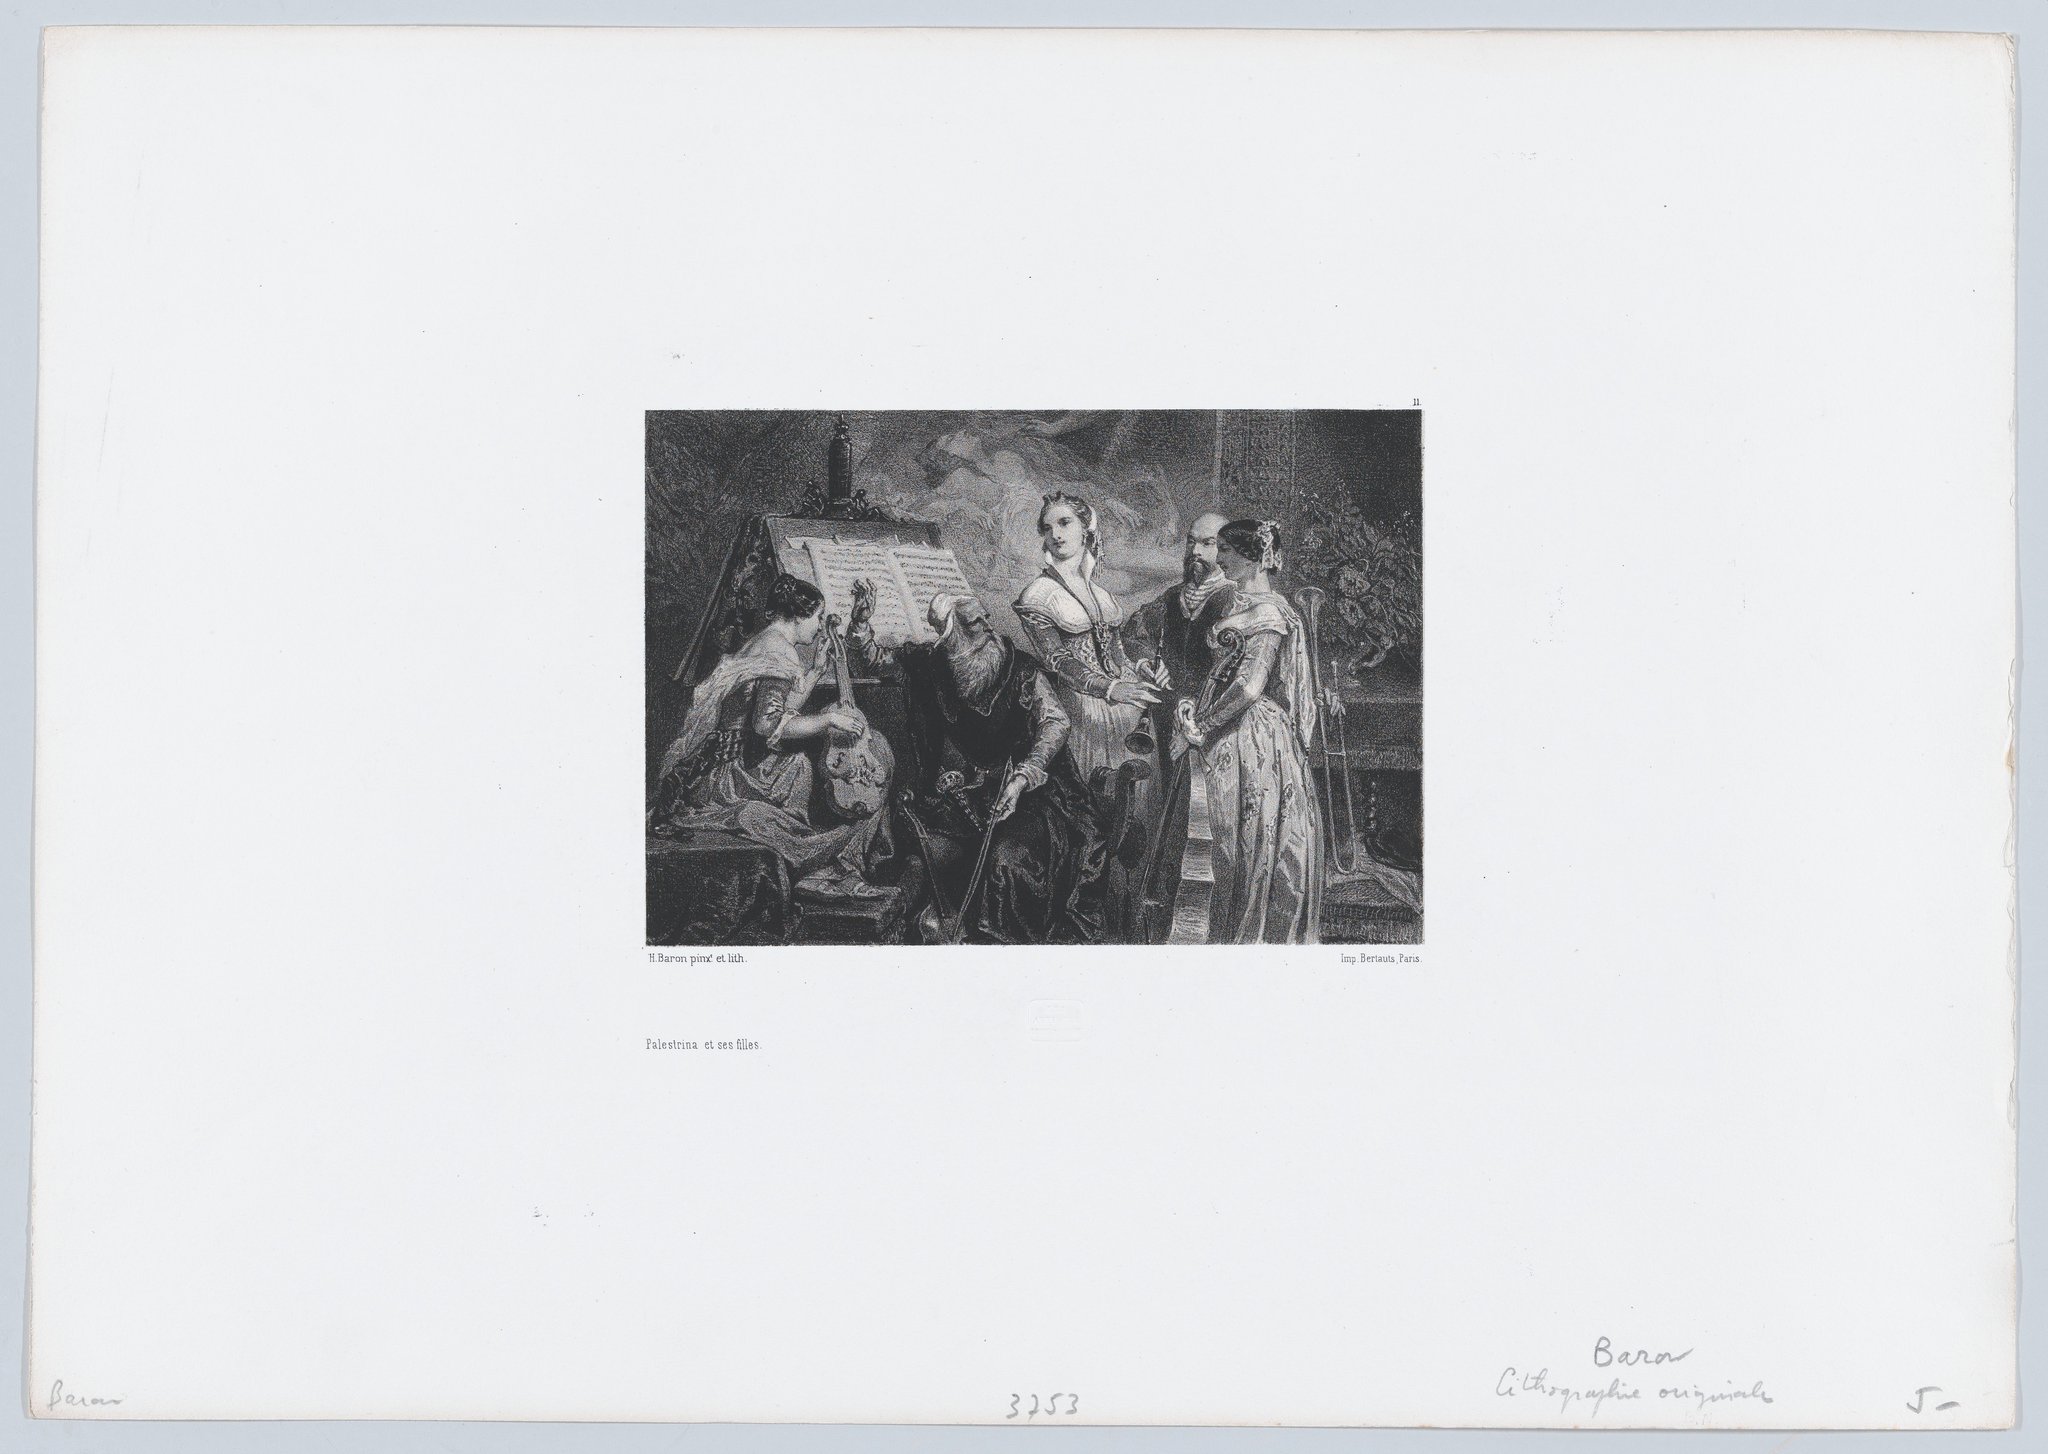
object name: print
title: Palestrina and Her Daughters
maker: henri-charles-antoine baron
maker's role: artist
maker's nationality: french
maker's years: 1816-1885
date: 1853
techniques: lithograph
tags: musical instruments,men,mothers,women